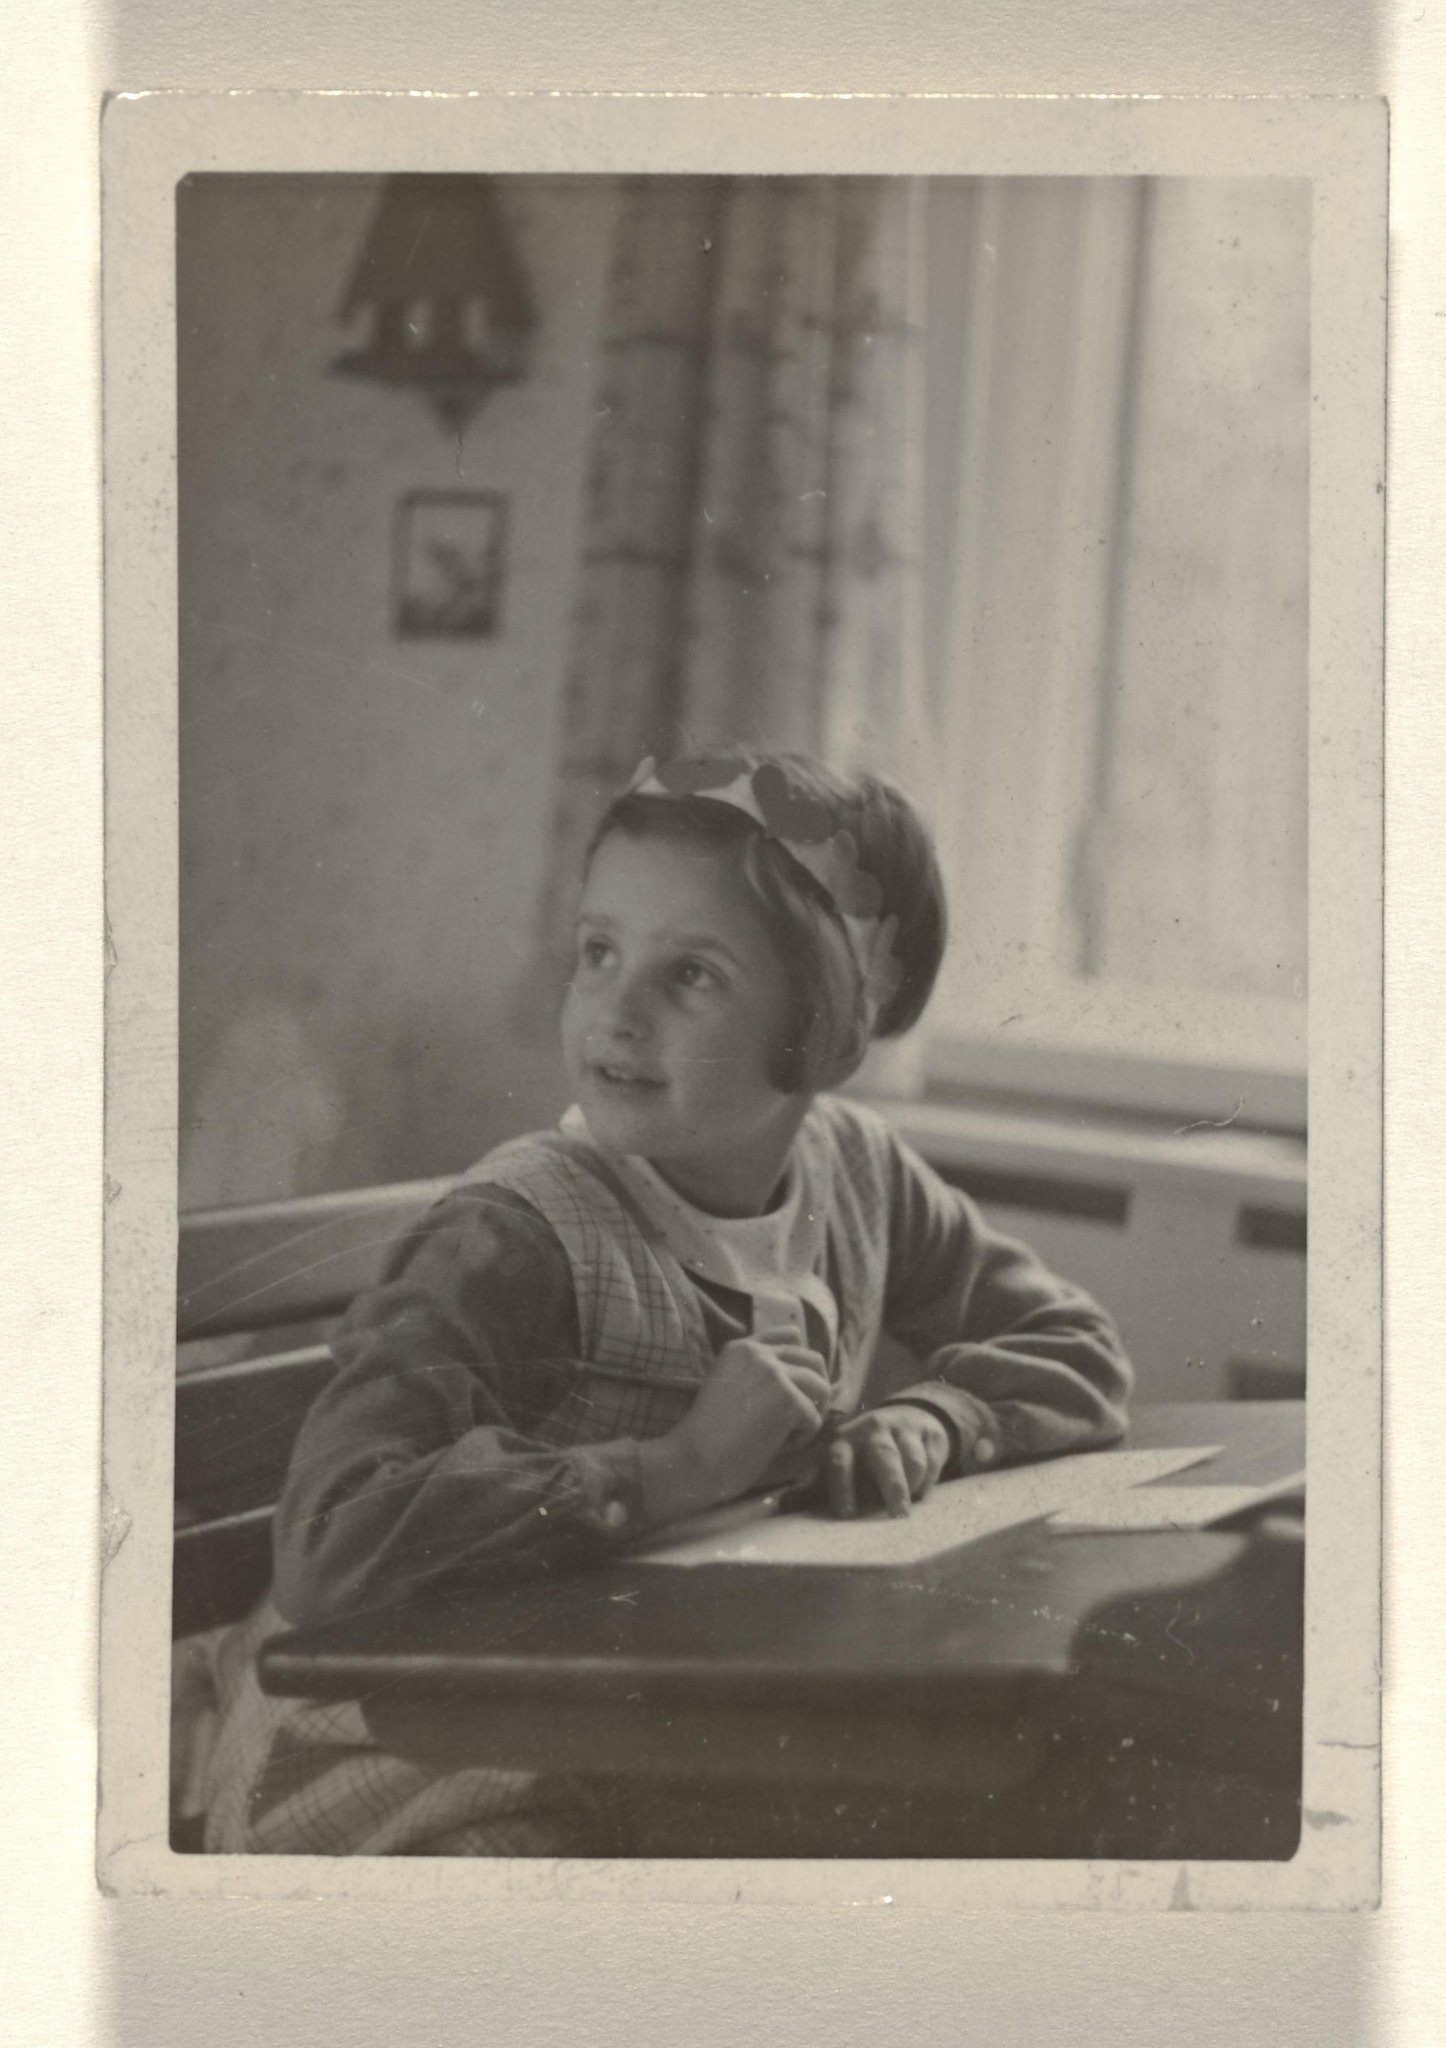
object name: photograph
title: Isabel Wachenheimer schrijvend aan een lessenaar, 1936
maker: Anonymous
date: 1936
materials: photographic support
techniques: gelatin silver print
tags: leiden, isabel wachenheimer-elon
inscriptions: inscription: ‘Isabel [...] 1936’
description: Isabel Wachenheimer met kroon in het haar schrijvend aan een lessenaar.